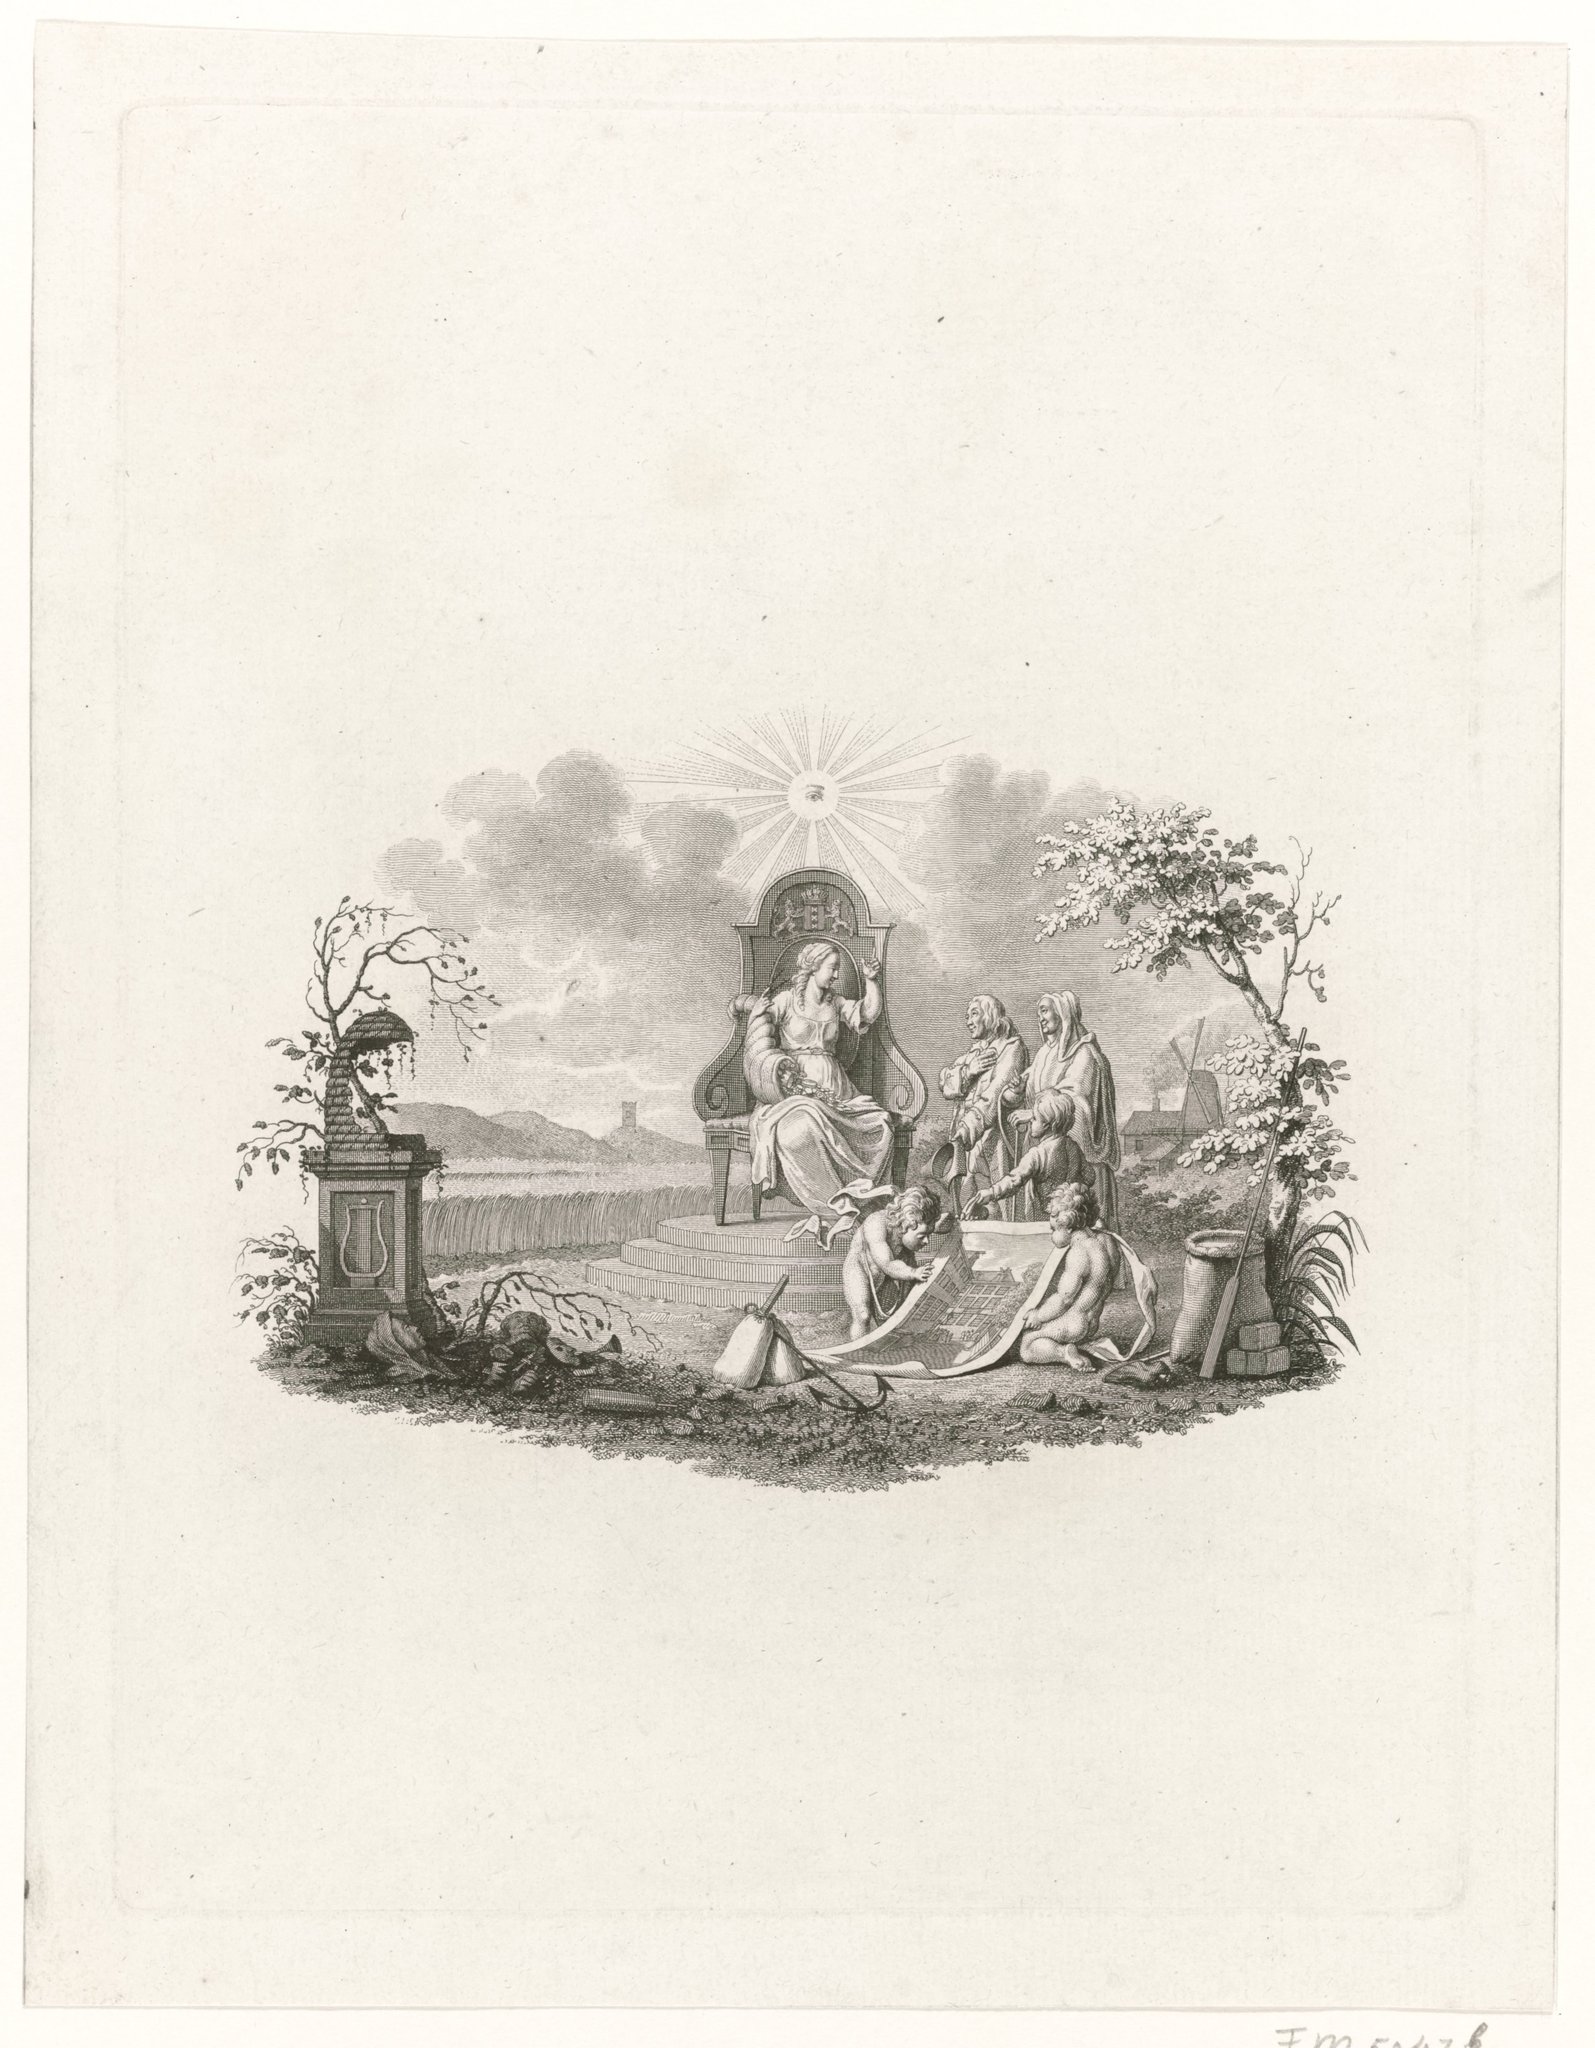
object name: print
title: Allegorie op de hulp verstrekt aan katholieke armen te Amsterdam, 5 december 1787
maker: noach van der meer (ii)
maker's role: draughtsman, print maker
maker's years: 1741-1822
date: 1787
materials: paper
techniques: engraving, etching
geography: northern netherlands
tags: generosity, liberality; 'generosità', 'liberalità' (ripa) (+ abstract concept represented by female figure), amsterdam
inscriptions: collector's mark: Lugt 2228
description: Allegorie op de hulp verstrekt aan katholieke armen te Amsterdam, 5 december 1787. De Mildheid zit op een troon met het Amsterdamse wapen en een hoorn van overvloed in de armen, voor haar dankbare katholieke man, vrouw en kind; twee putti bekijken een blad met een voorstelling van het Roomse Armenkantoor op de Keizersgracht 384. In de hemel het Alziende Oog.